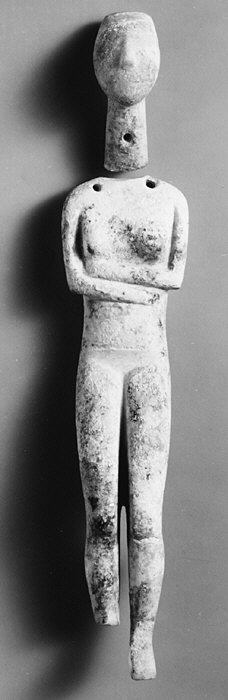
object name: statuette of a woman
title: Marble female figure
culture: cycladic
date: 2700-2500 BCE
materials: marble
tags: women